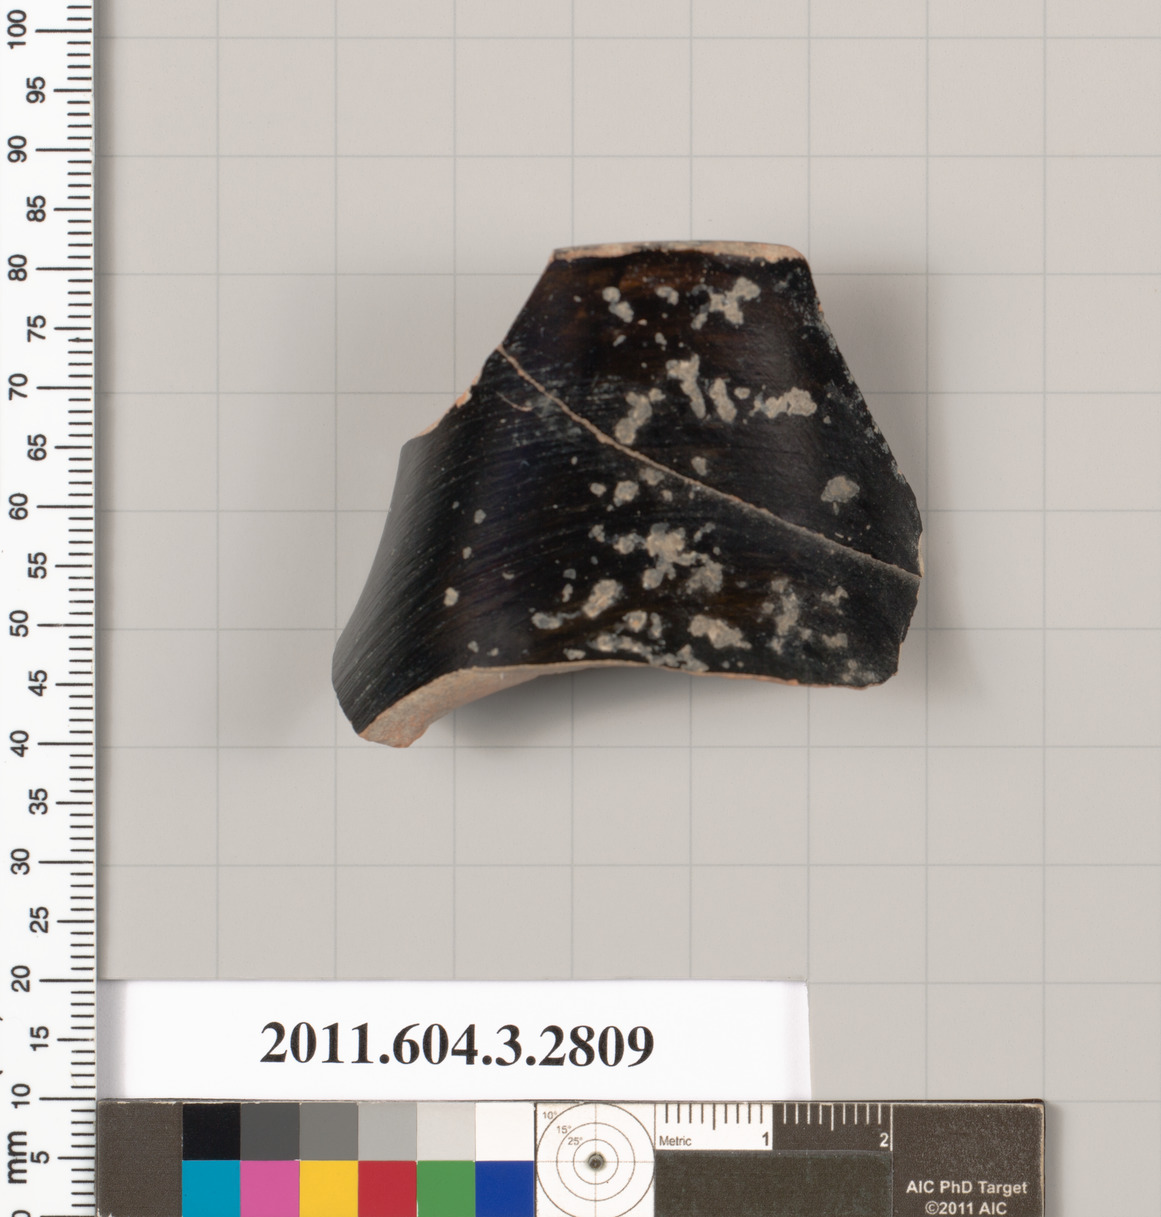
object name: oinochoe fragment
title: Terracotta fragment of a beaked oinochoe (jug)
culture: greek, attic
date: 500-401 BCE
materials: terracotta